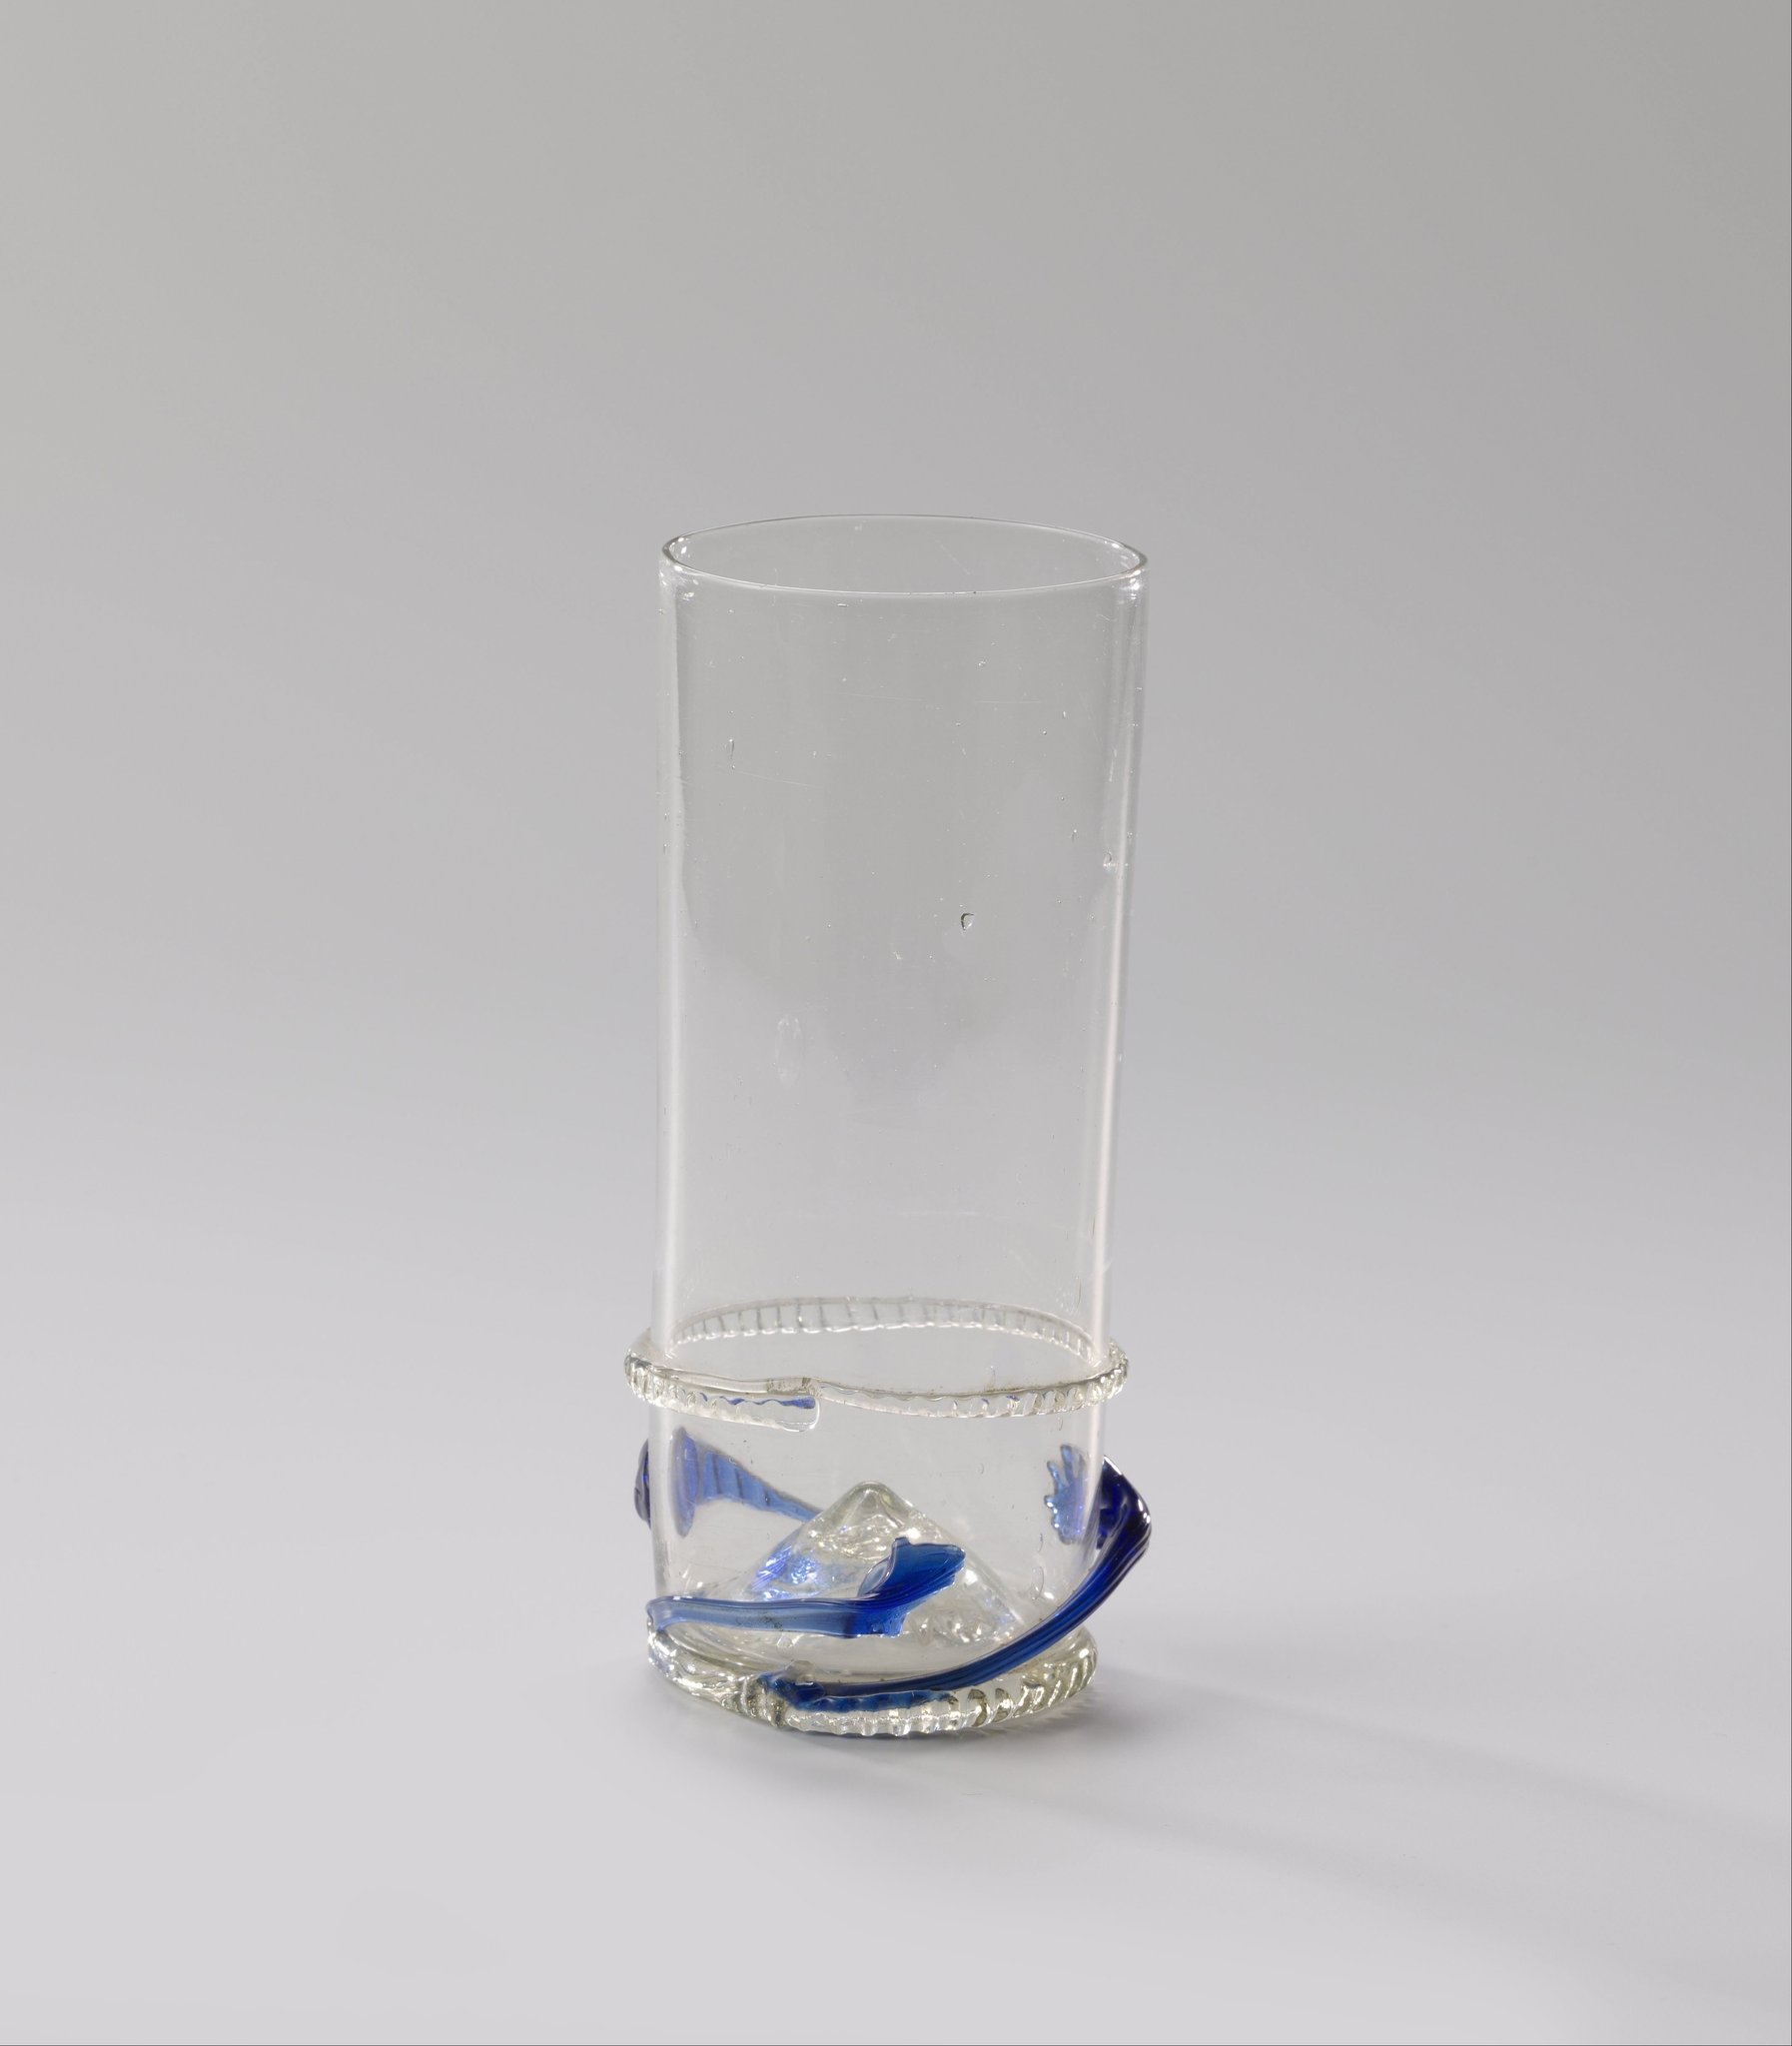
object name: kometenbeker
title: Beaker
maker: Anonymous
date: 1550-1700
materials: glass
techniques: façon de venise, glassblowing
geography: low countries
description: Kometenbeker met ingestoken bodem. Geribde standring. Cilindervormig lichaam met op eenvierde van de hoogte een geribde draad. Daaronder zijn drie schuine gegolfde draden van blauw glas aangebracht, die eindigen in klauwen